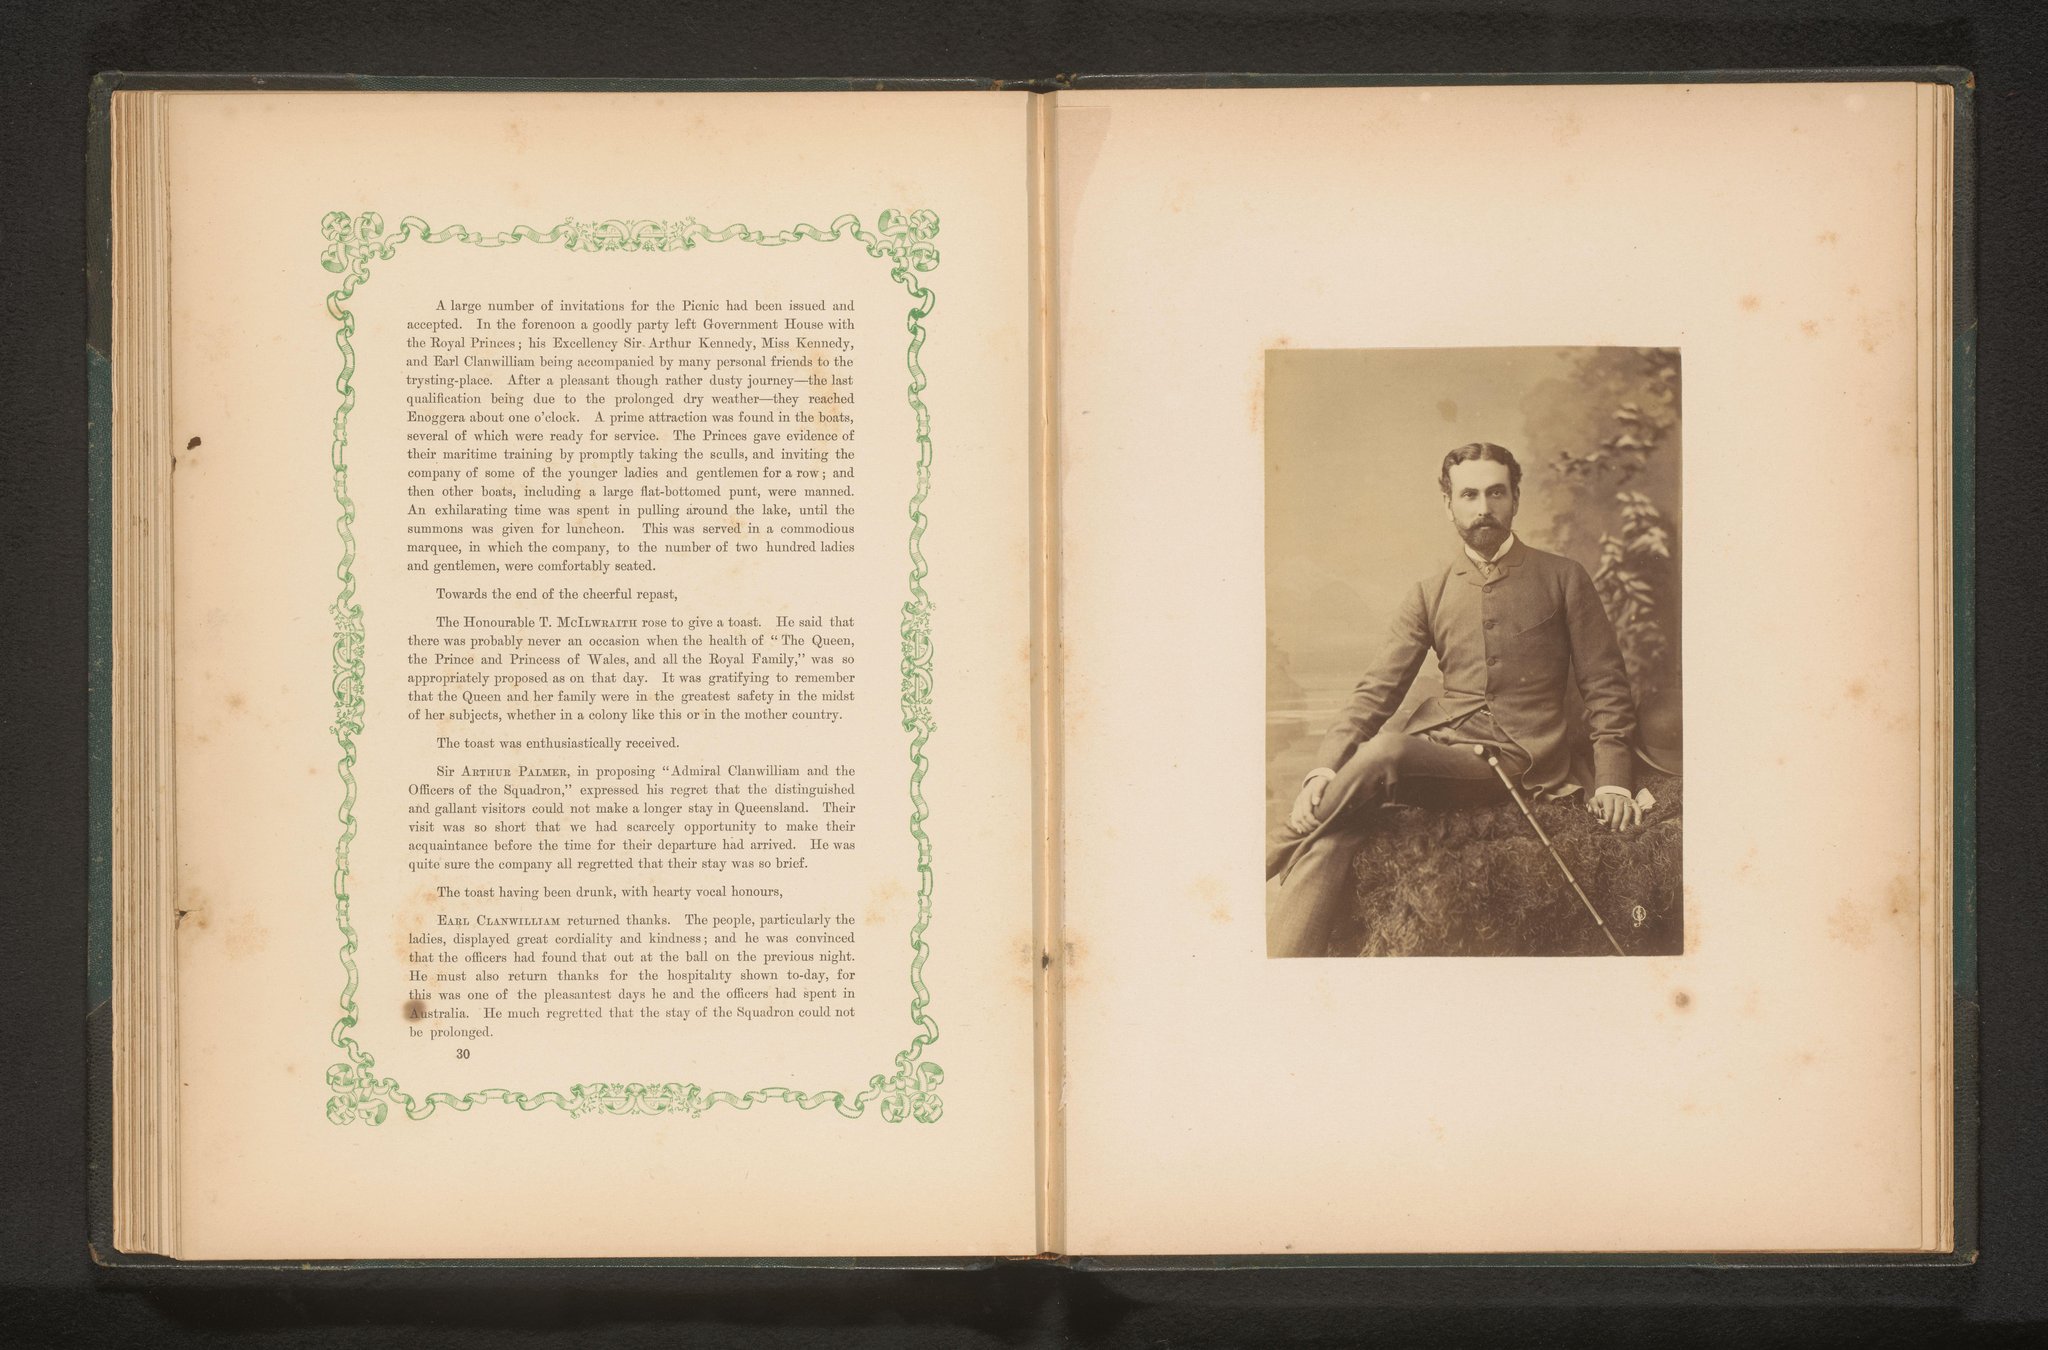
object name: photograph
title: Portret van prins Lodewijk Alexander van Battenberg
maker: Anonymous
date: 1880-1881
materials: photographic support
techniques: albumen print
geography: brisbane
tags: prince